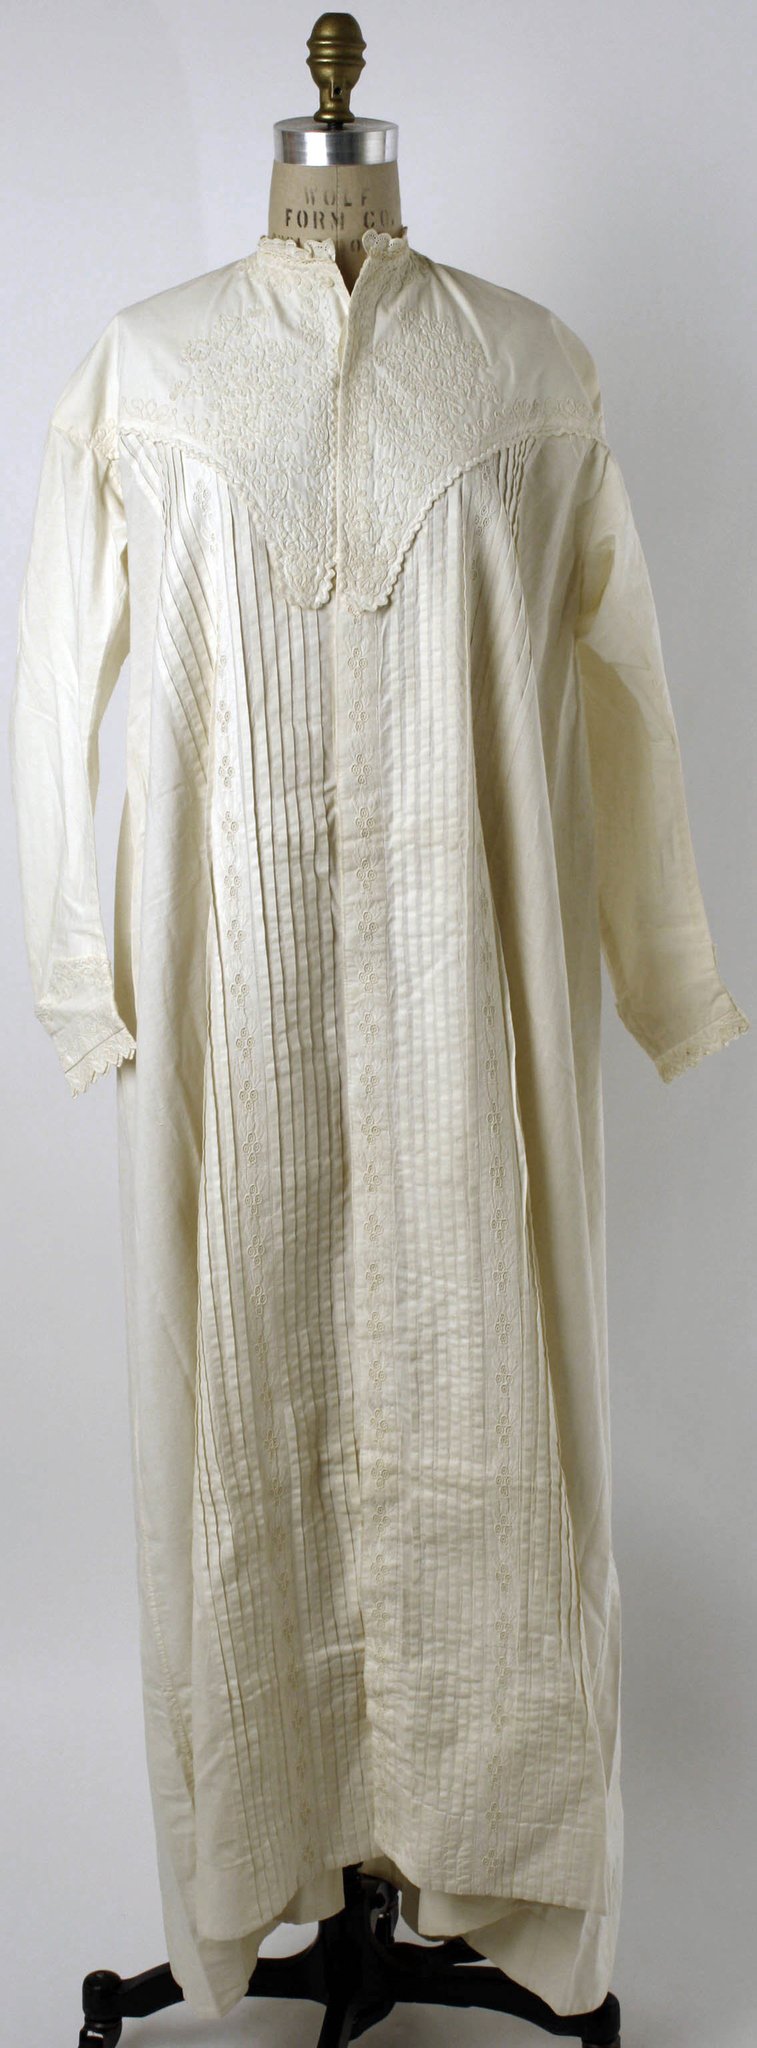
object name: nightgown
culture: american or european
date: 1860-1869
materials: cotton